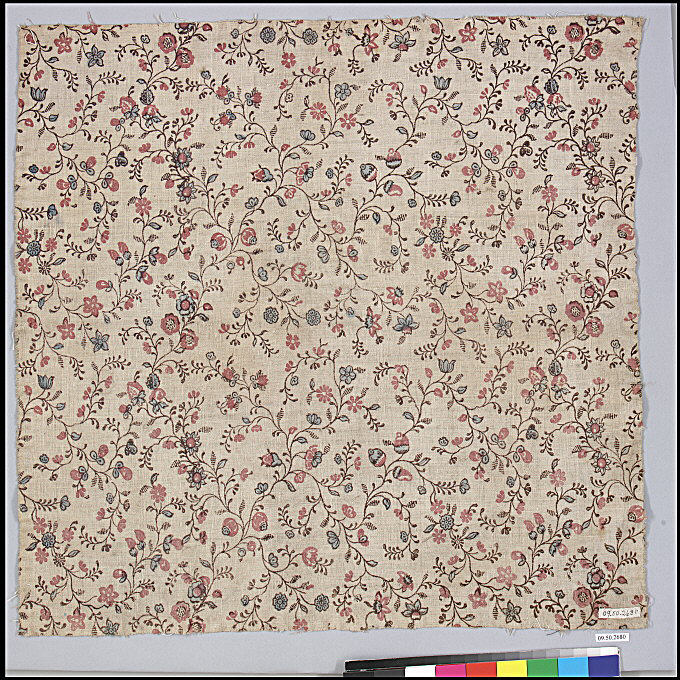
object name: fragment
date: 1734-1766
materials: linen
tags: flowers,leaves